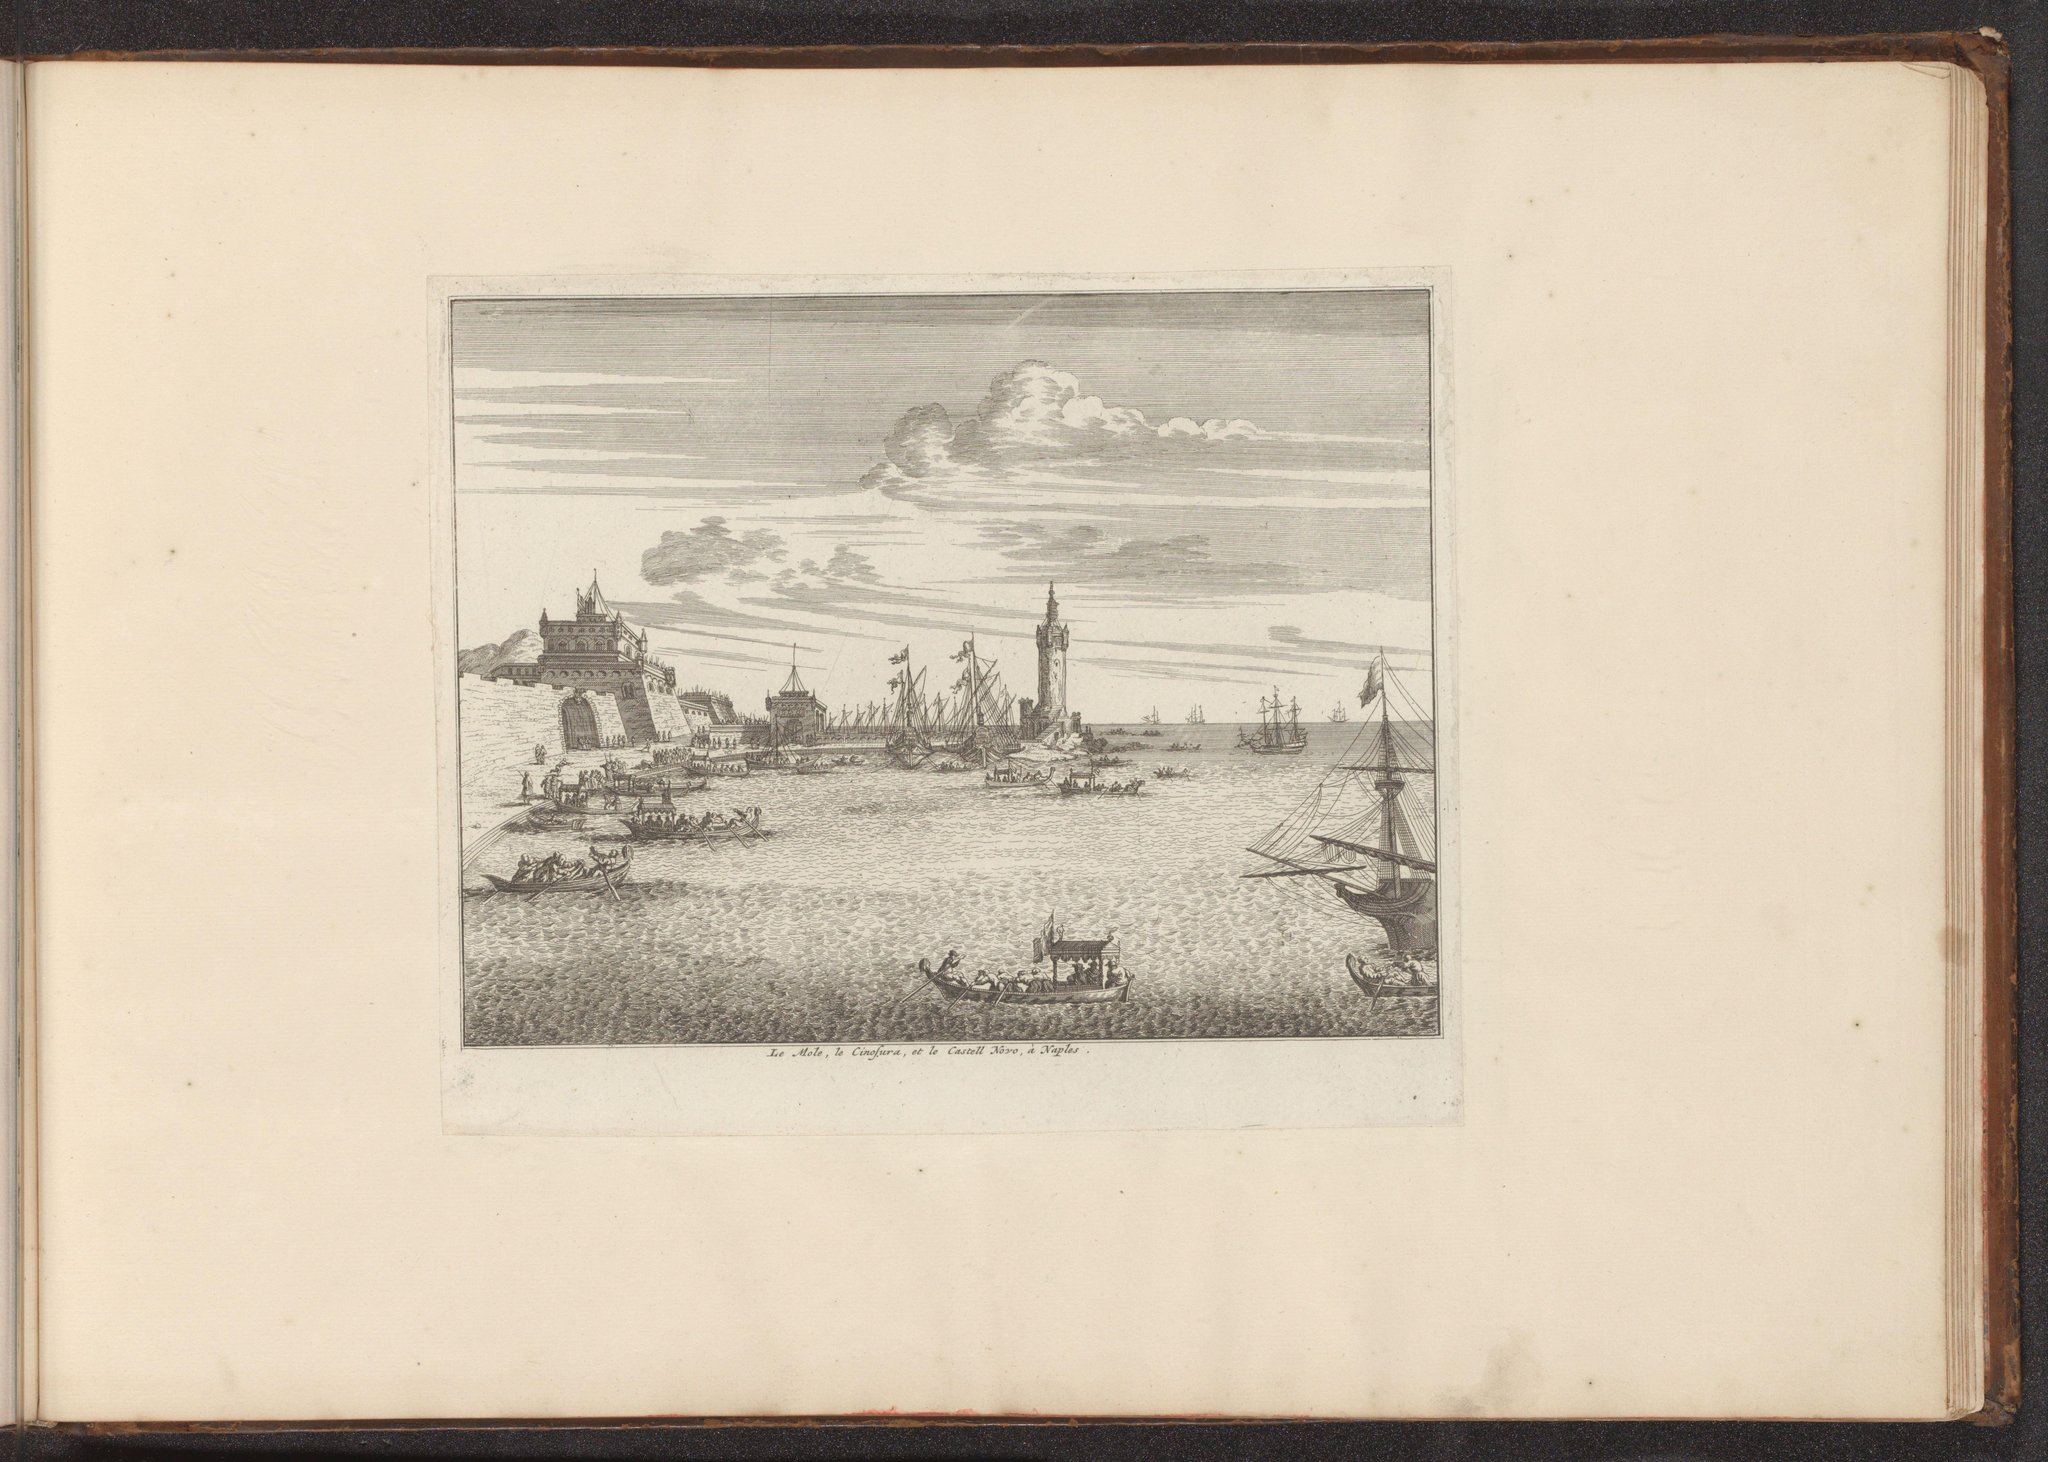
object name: print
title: Le Mole, le Cinosura, et le Castell Novo, à Naples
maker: Anonymous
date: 1700-1710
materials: paper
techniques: etching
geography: france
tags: harbour, ships (in general), hôtel, i.e. small palace in city, sea, naples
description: Gezicht op de haven met een vuurtoren en een paleis te Napels. Verschillende boten en schepen varen de haven binnen. De prent maakt deel uit van een album.